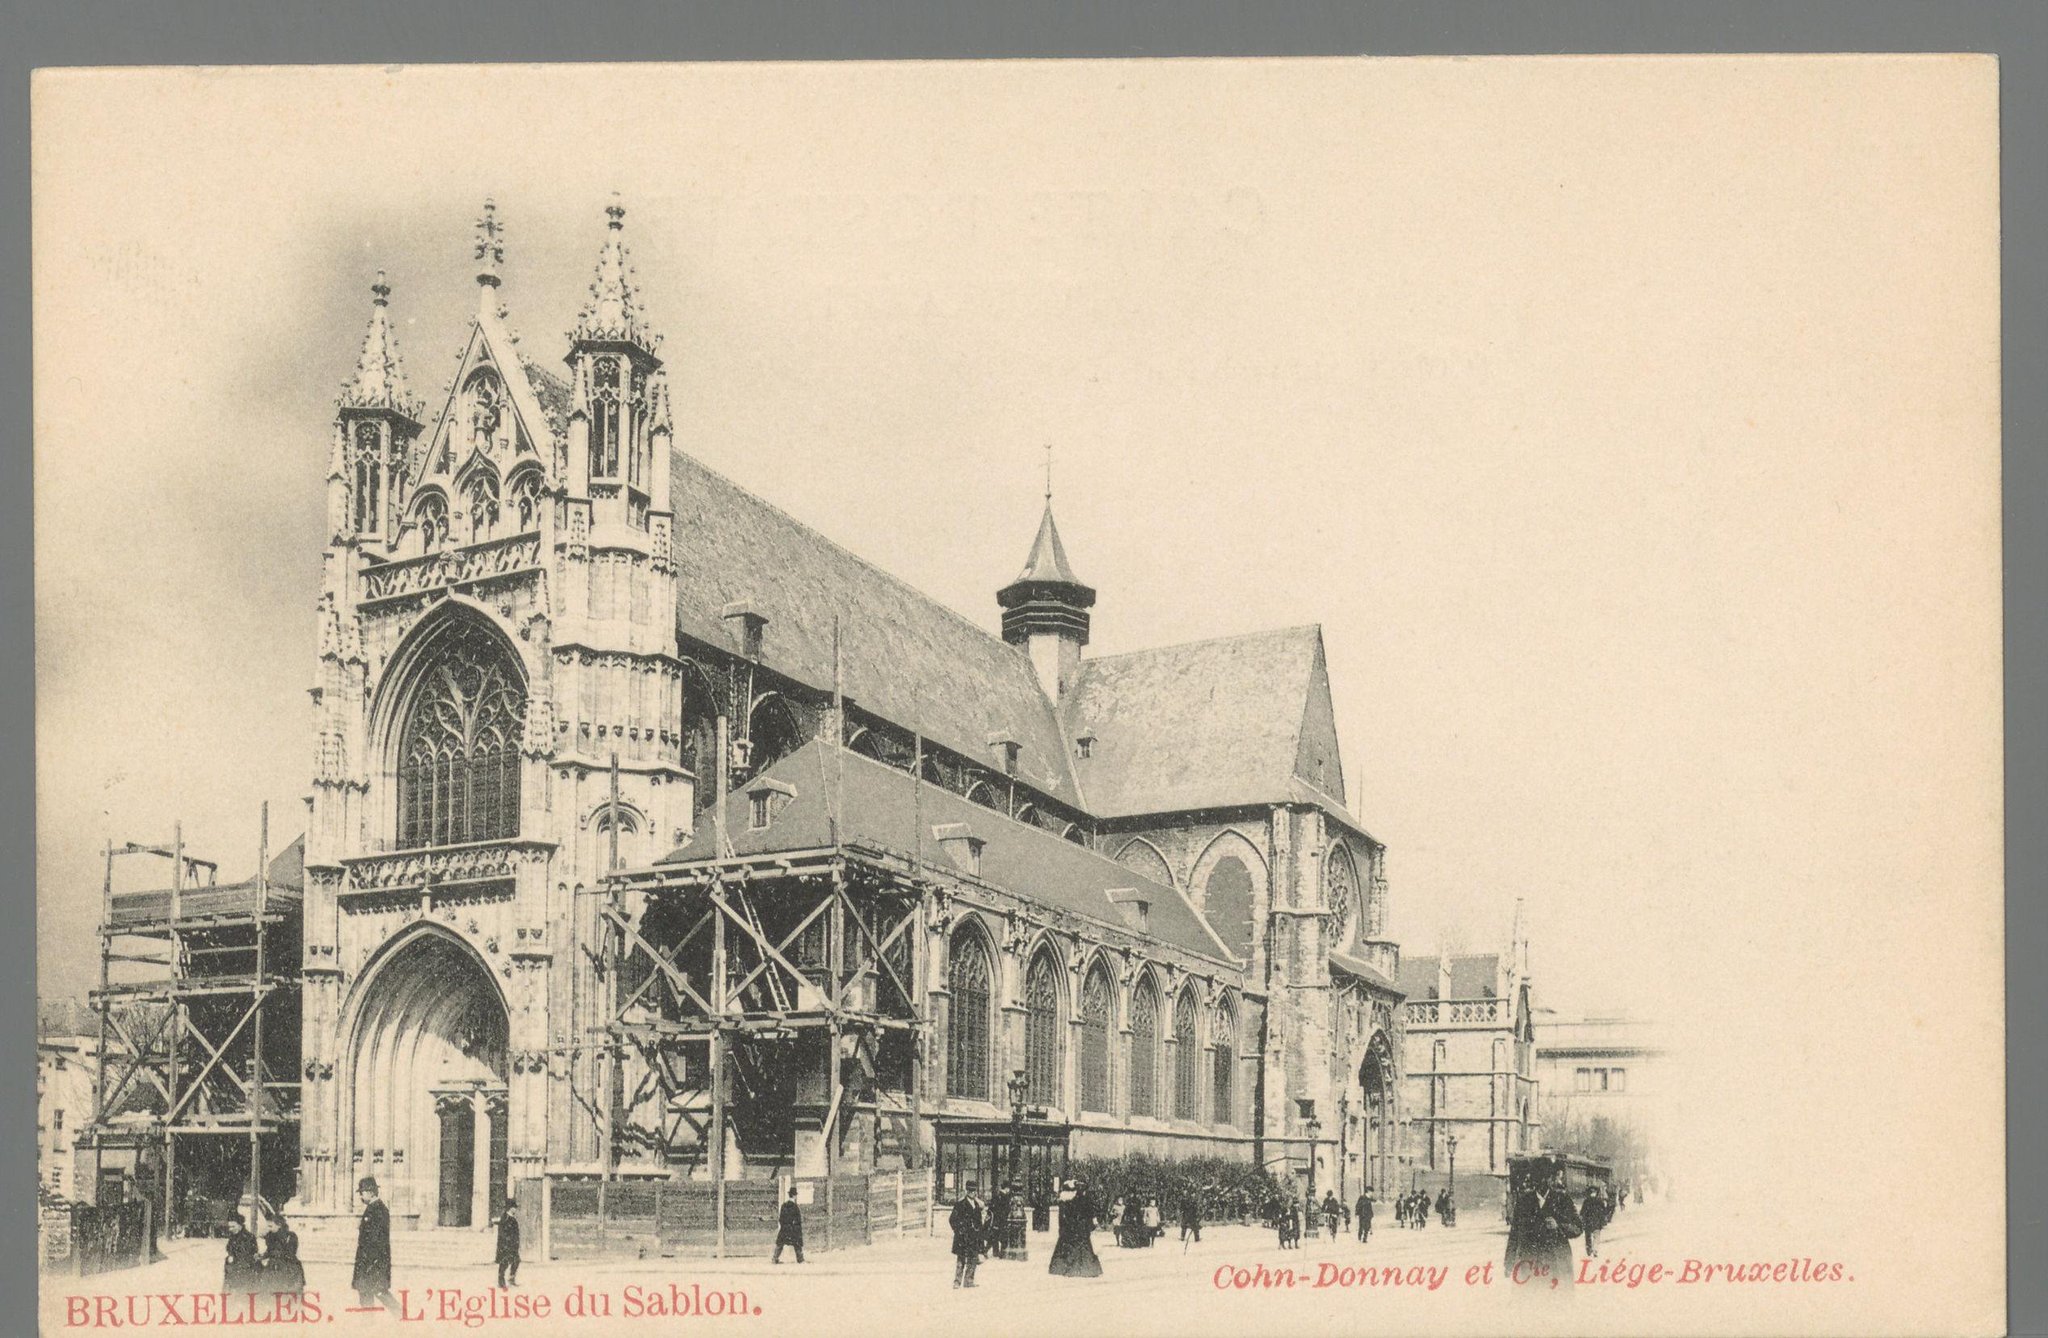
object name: photomechanical print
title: Bruxelles. L'Eglise du Sablon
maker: Anonymous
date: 1903-1906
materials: cardboard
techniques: photograph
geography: brussels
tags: scaffold (~ building activities), church (exterior), city-view, and landscape with man-made constructions (+ city(-scape) with figures, staffage)